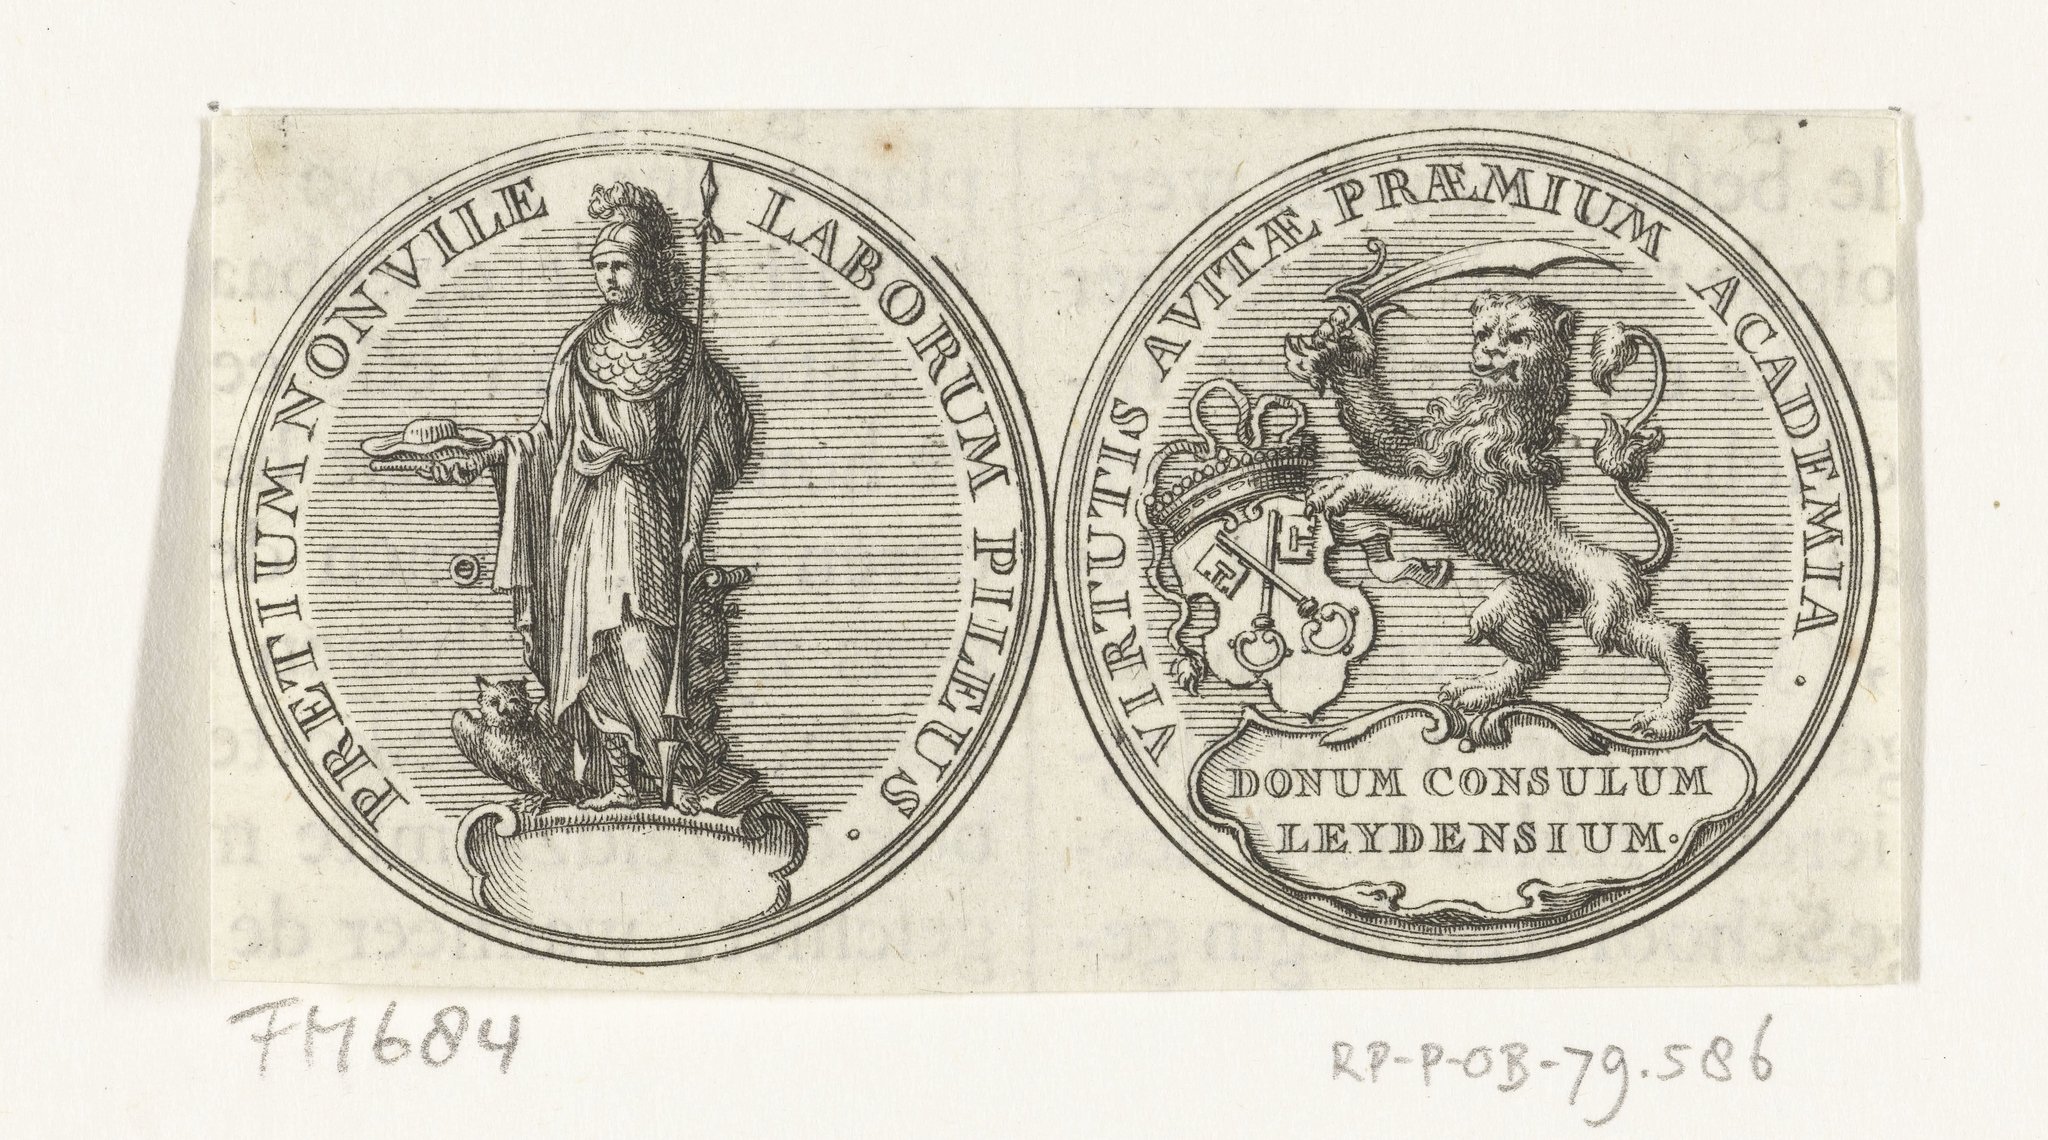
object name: historical object representation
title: Penning met Minerva en leeuw met wapen van Leiden, 1574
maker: Anonymous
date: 1721-1723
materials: paper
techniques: etching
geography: northern netherlands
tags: medal (considered as a piece of sculpture, regardless of its specific function), leiden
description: Penning met Minerva en leeuw met wapen van Leiden, 1574. Gouden penning. Voorzijde: staande Minerva met land en vrijheidshoed. Keerzijde: Leeuw met zwaard en gekroond wapenschild van Leiden. Geschonken door de burgemeesters van Leiden bij inhuldiging van nieuwe hoogleraar aan de universiteit. Bedrukt op achterzijde met tekst in het Nederlands.